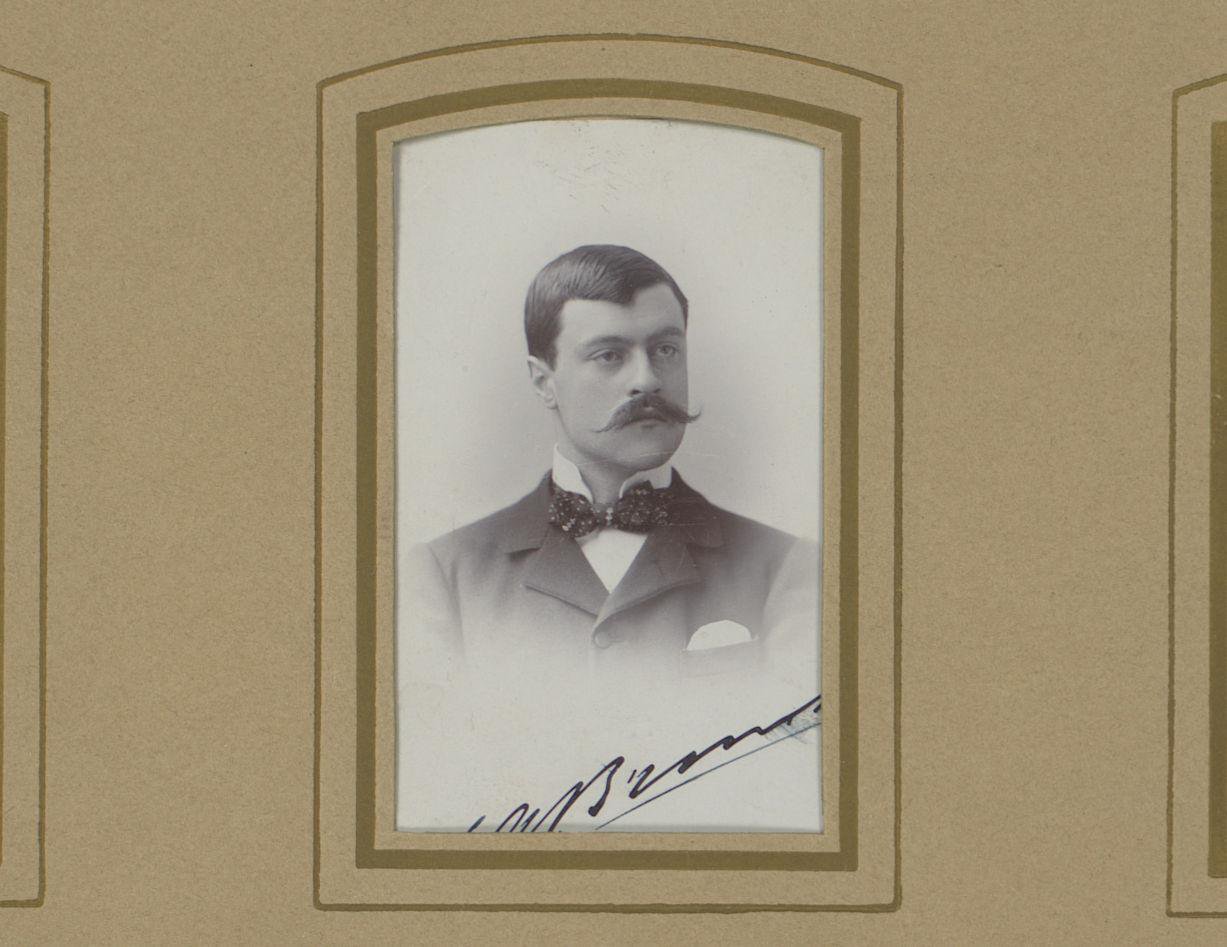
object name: carte de visite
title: Portret van een man met vlinderstrik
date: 1894-1907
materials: cardboard, photographic support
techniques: matte daylight collodion silver print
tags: historical persons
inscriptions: name: ‘[...] Br[...]’, inscription: ‘[Koene & Büttinghausen]/ Amsterdam/ Heerengracht 150./ Batavia.’